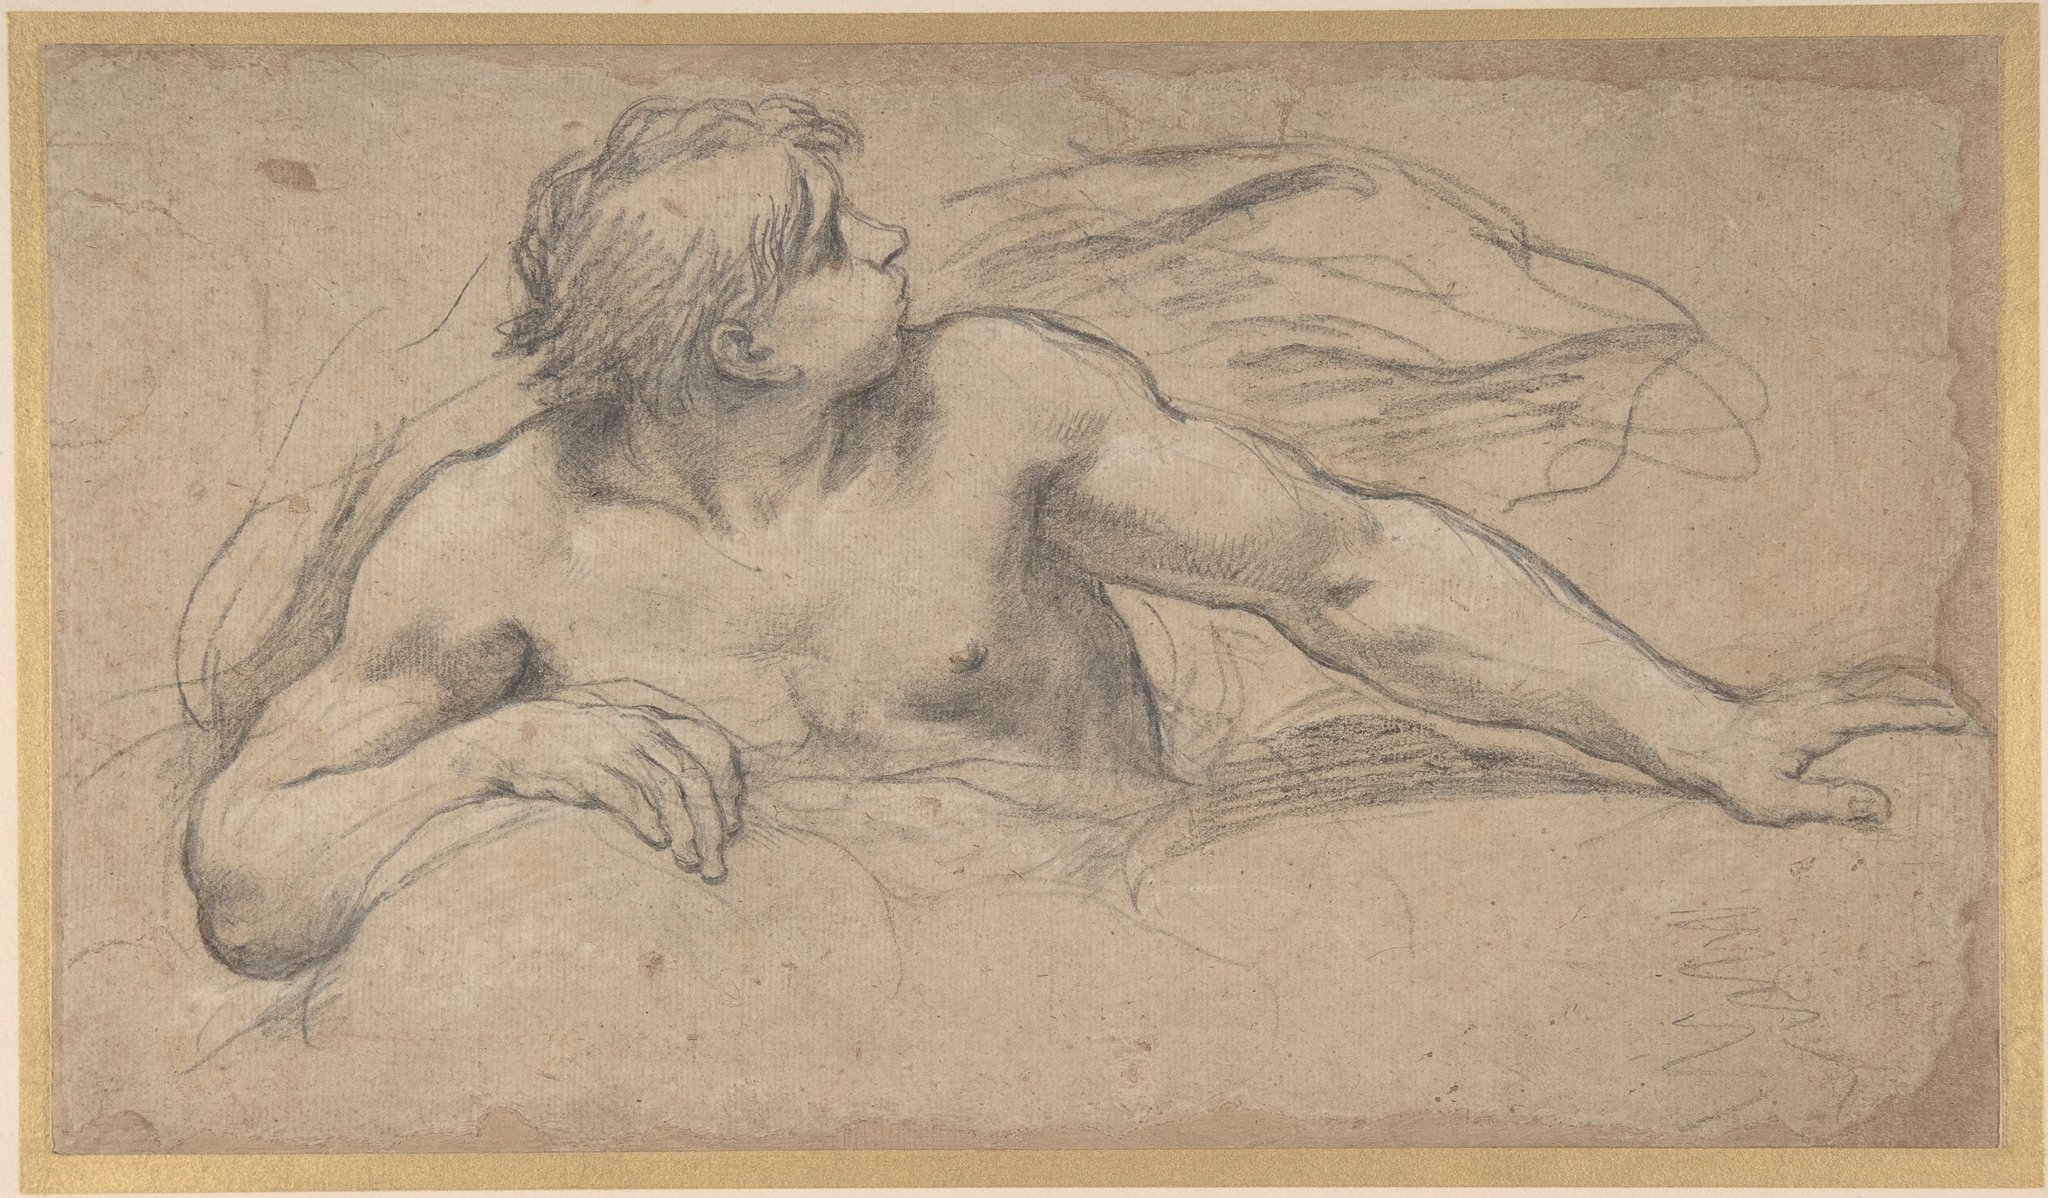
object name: drawing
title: A Wind God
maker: pietro da cortona (pietro berrettini)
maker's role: artist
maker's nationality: italian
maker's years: 1596-1669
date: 1669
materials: chalk, paper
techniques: highlighting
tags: men